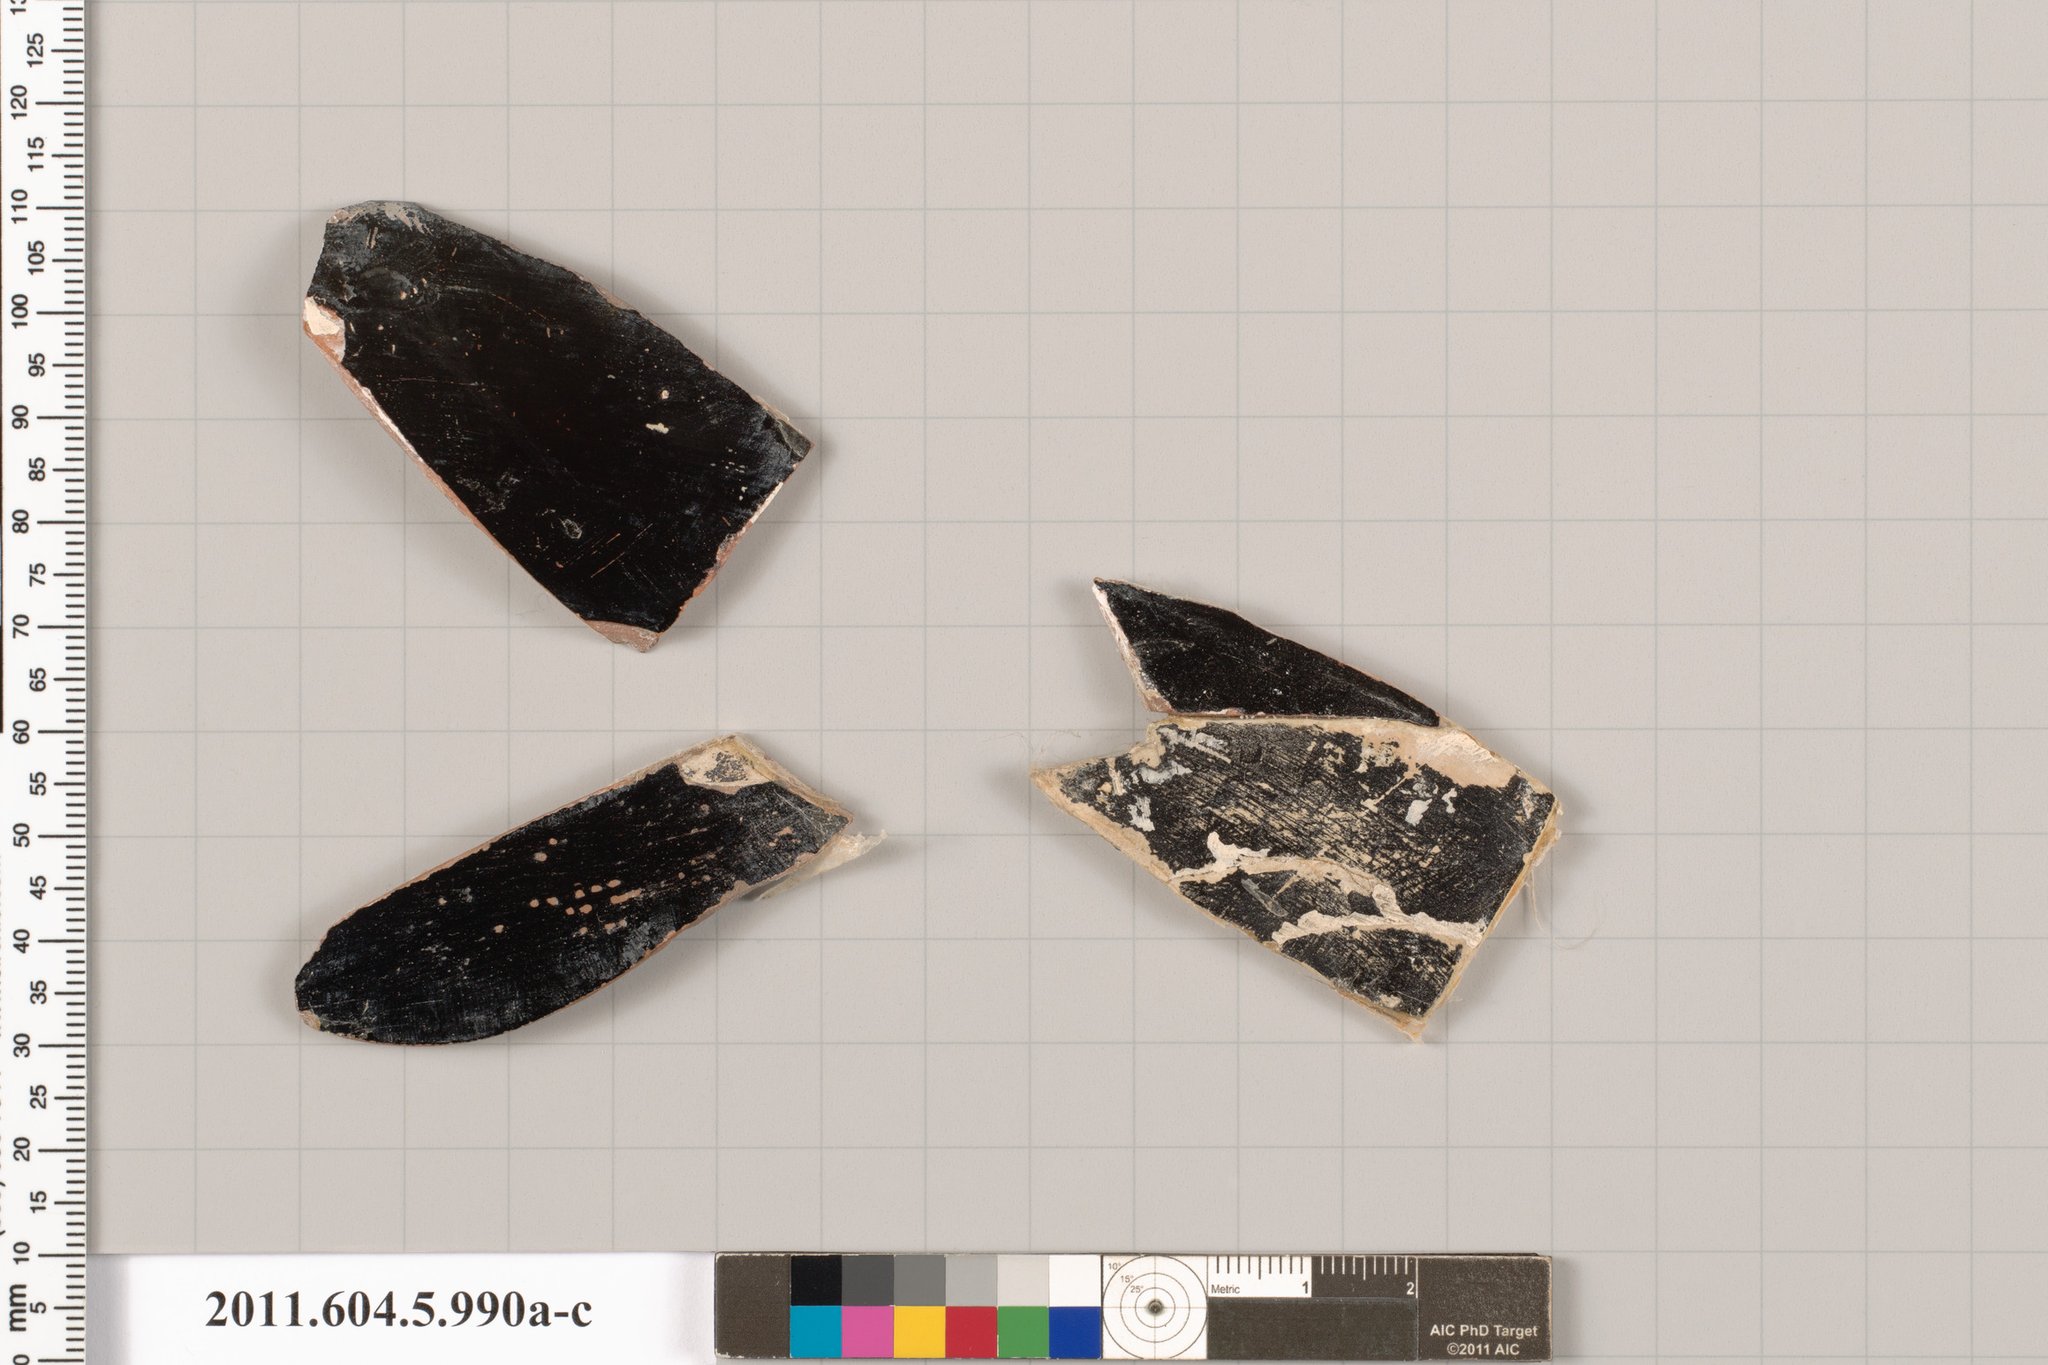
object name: kylix fragment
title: Terracotta fragments of kylikes (drinking cups)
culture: greek, attic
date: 600-401 BCE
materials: terracotta